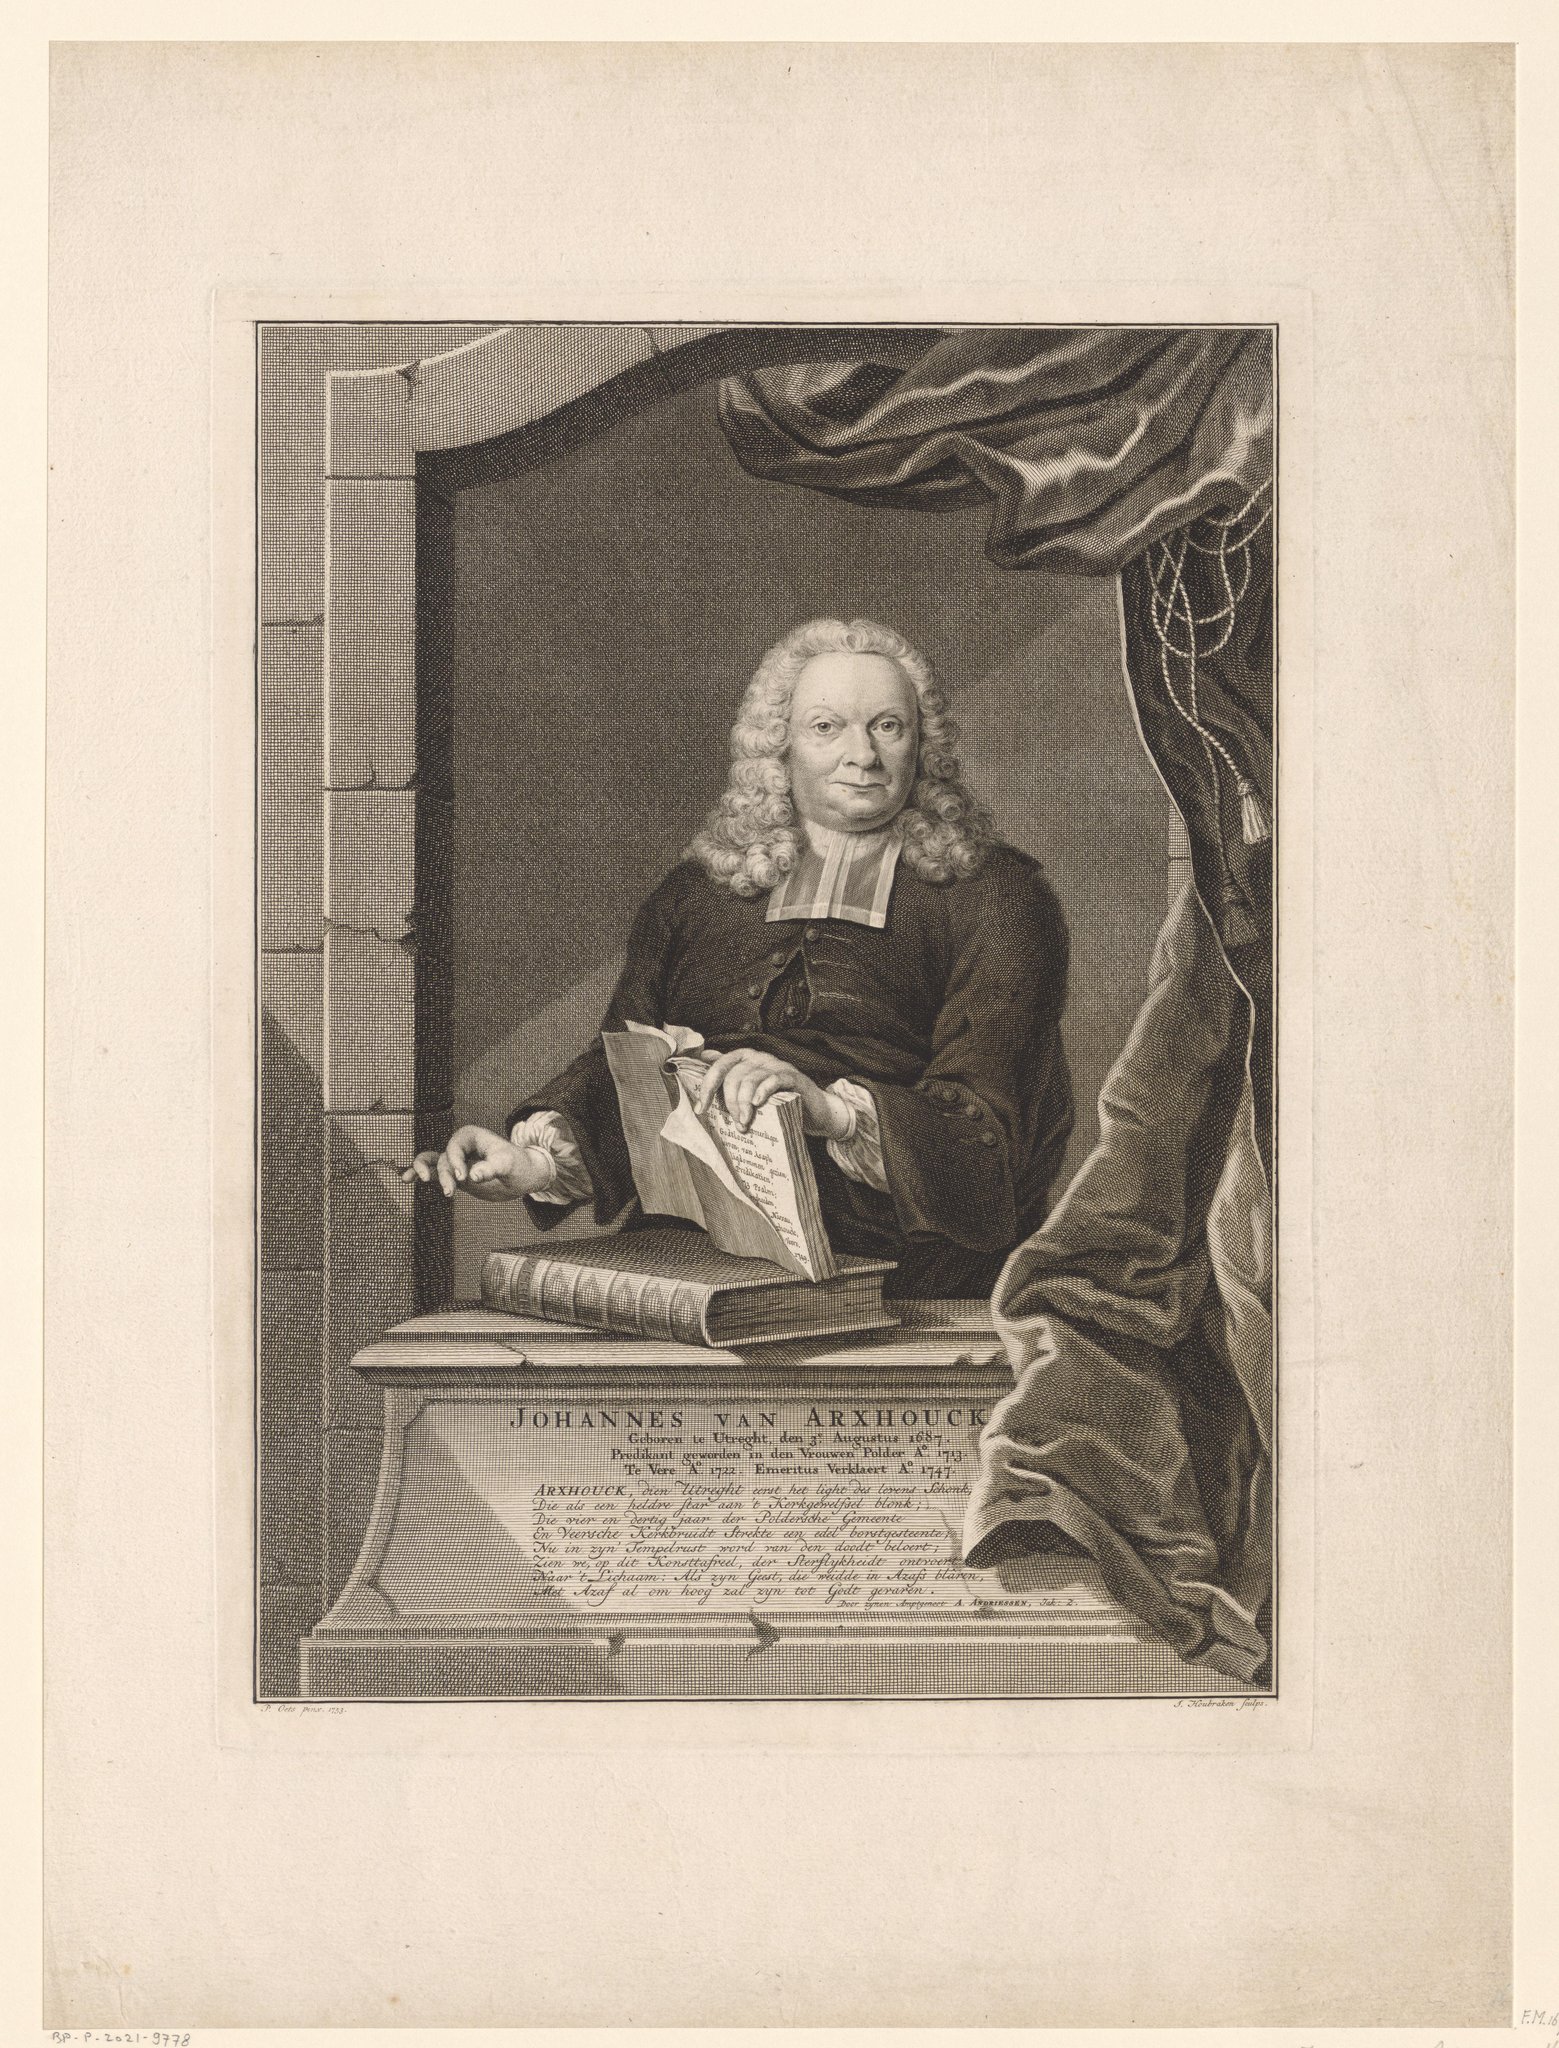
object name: print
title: Portret van Johannes van Arxhouck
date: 1753-1780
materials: paper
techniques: engraving, etching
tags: historical persons, functionaries and dignitaries ~ episcopal protestant churches, book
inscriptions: collector's mark: Lugt 2228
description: Het boek in de hand van de geportretteerde is: Arxhouck, Johannes van. Het gelukkig en ongelukkig einde der rechtveerdigen en der godtloozen (...) nader verklaert in eenige predikatien, over den LXXIII psalm. Amsterdam: Adriaan Wor en erven Gerard onder de Linden, 1749.